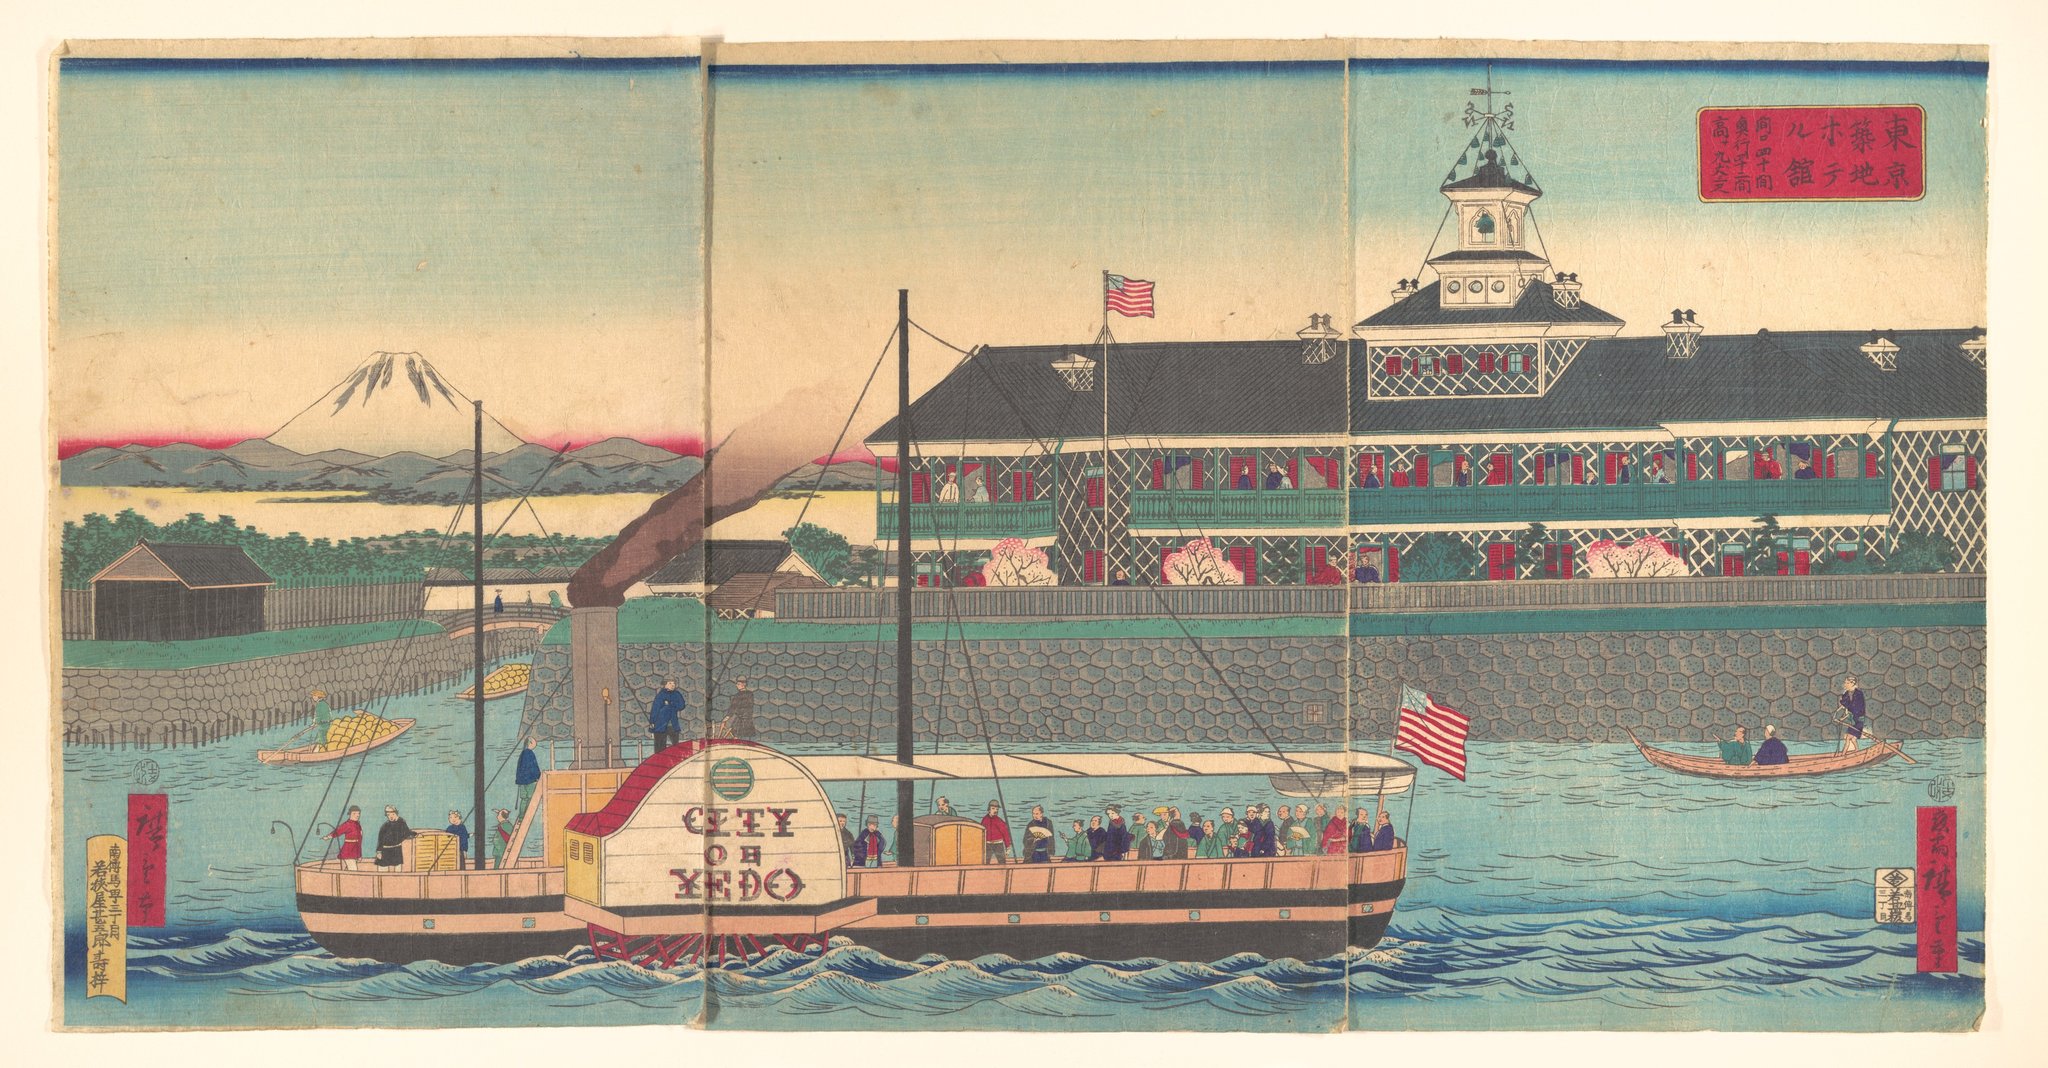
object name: print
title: The Tsukiji Hotel in Tokyo (Tokyo Tsukiji hoteru kan)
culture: japanese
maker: utagawa hiroshige iii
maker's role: artist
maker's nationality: japanese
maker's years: 1843-1894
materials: ink, paper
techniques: woodblock print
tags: hotels,ships